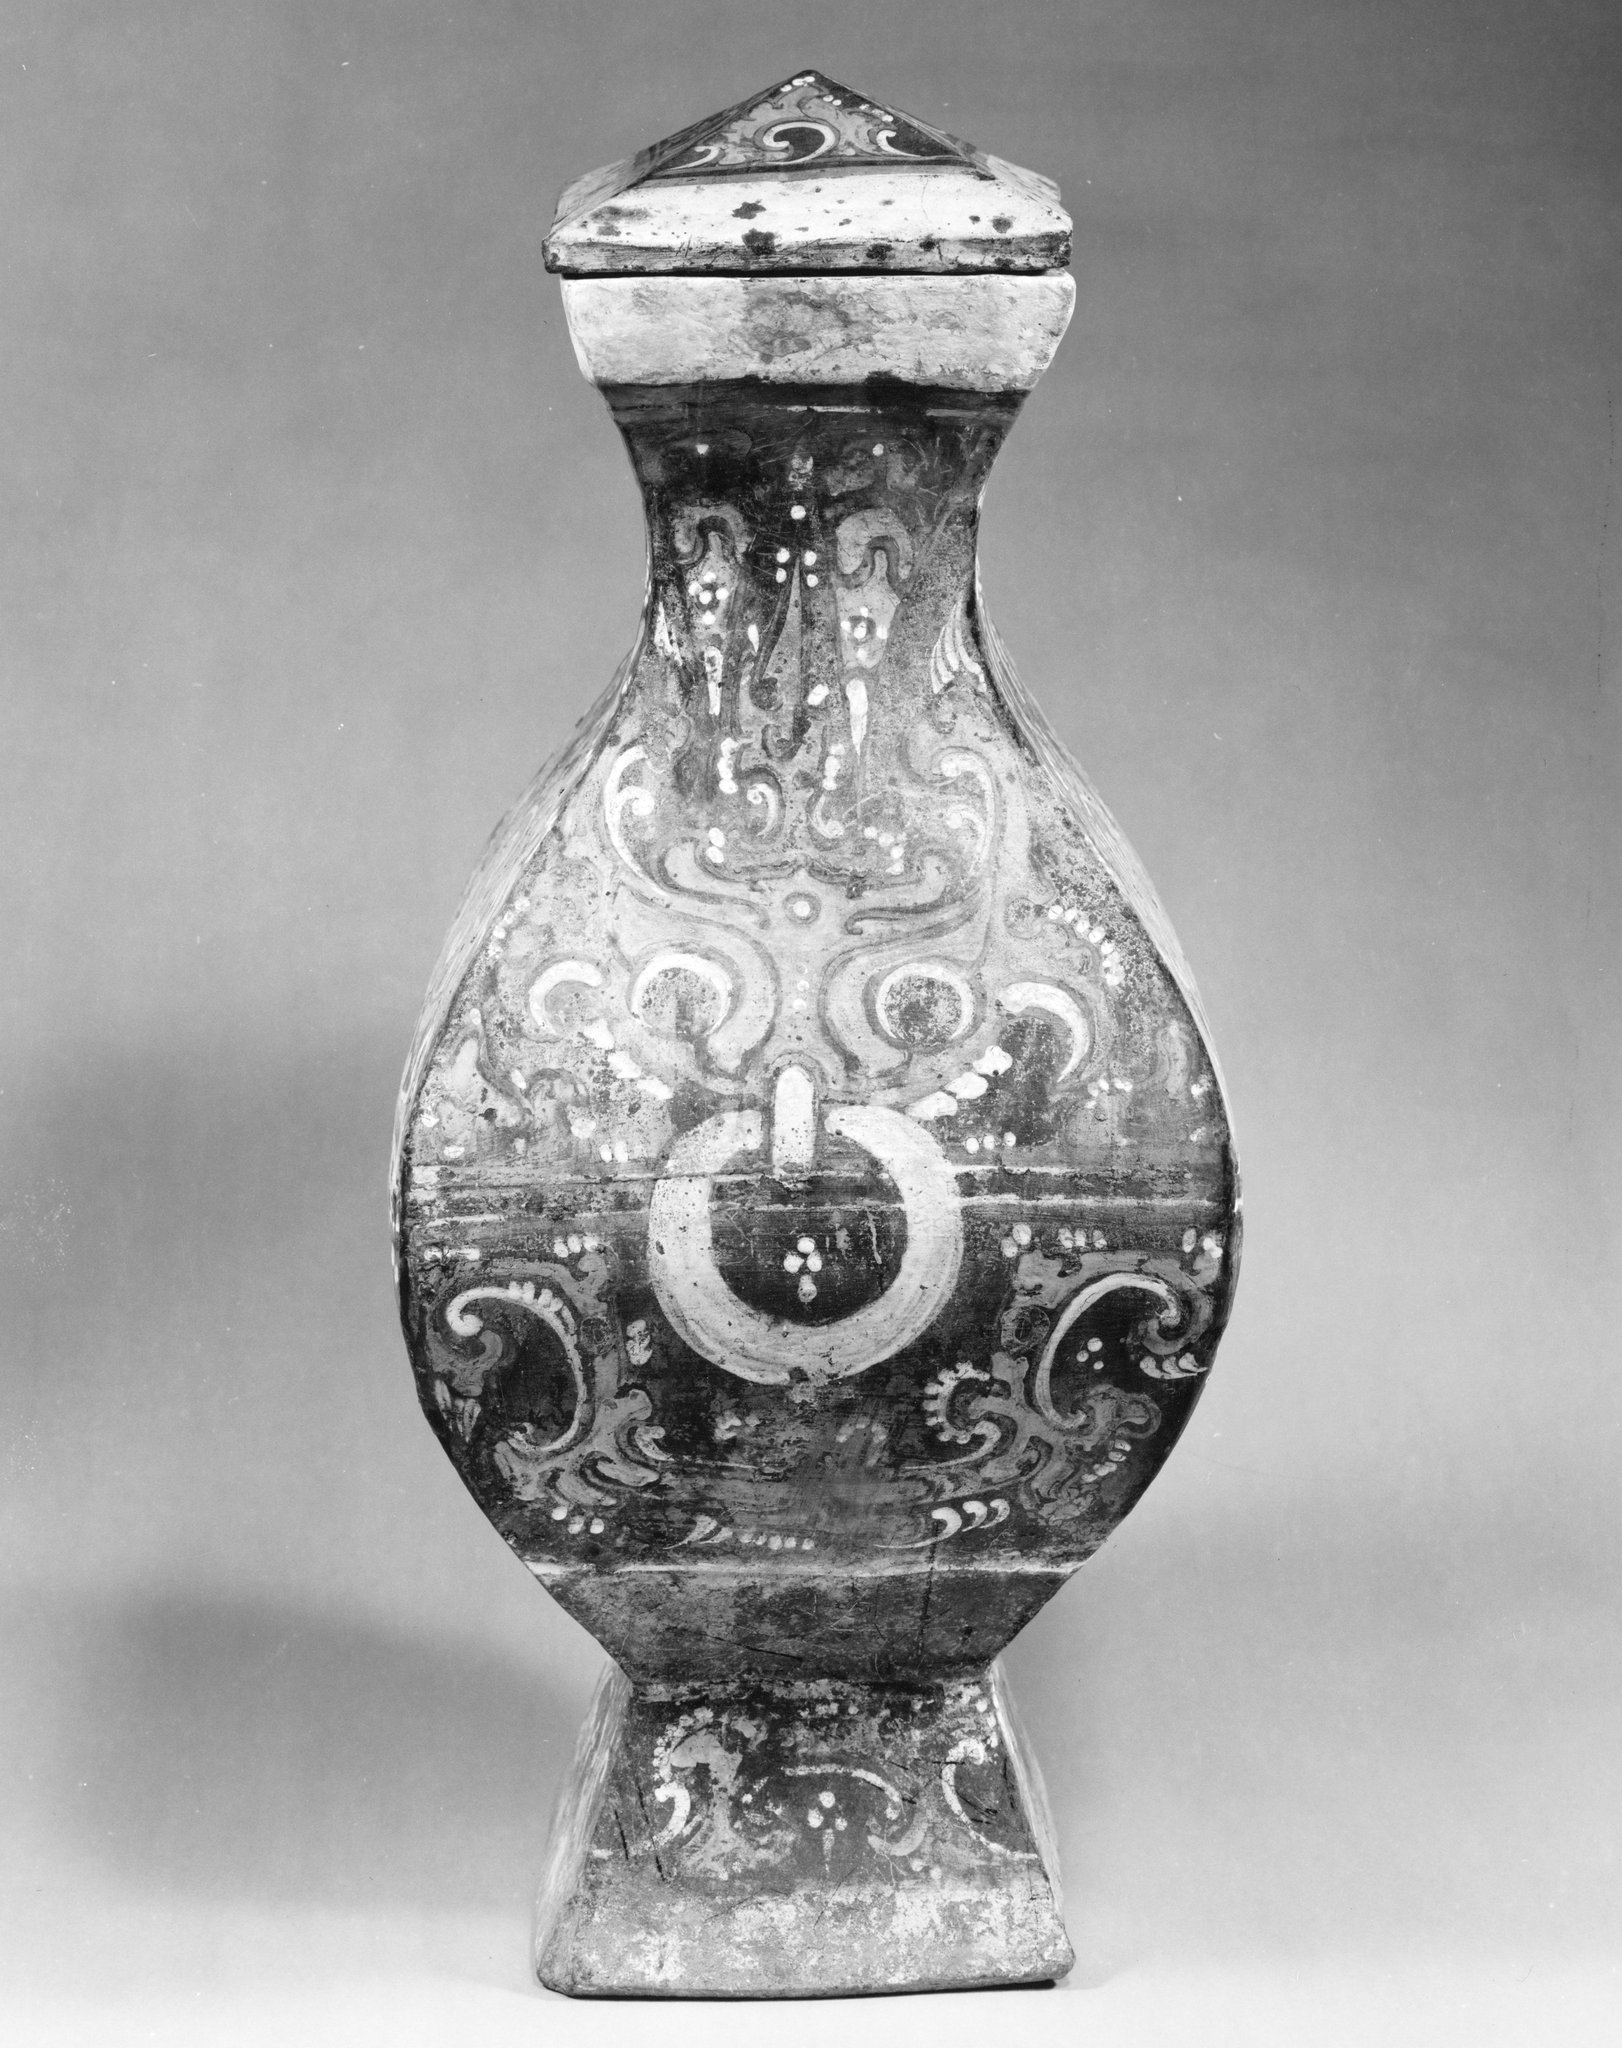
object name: jar with cover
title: Squared Jar with Cover (Fanghu)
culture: chinese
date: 206 BCE-220 CE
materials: earthenware, pigment